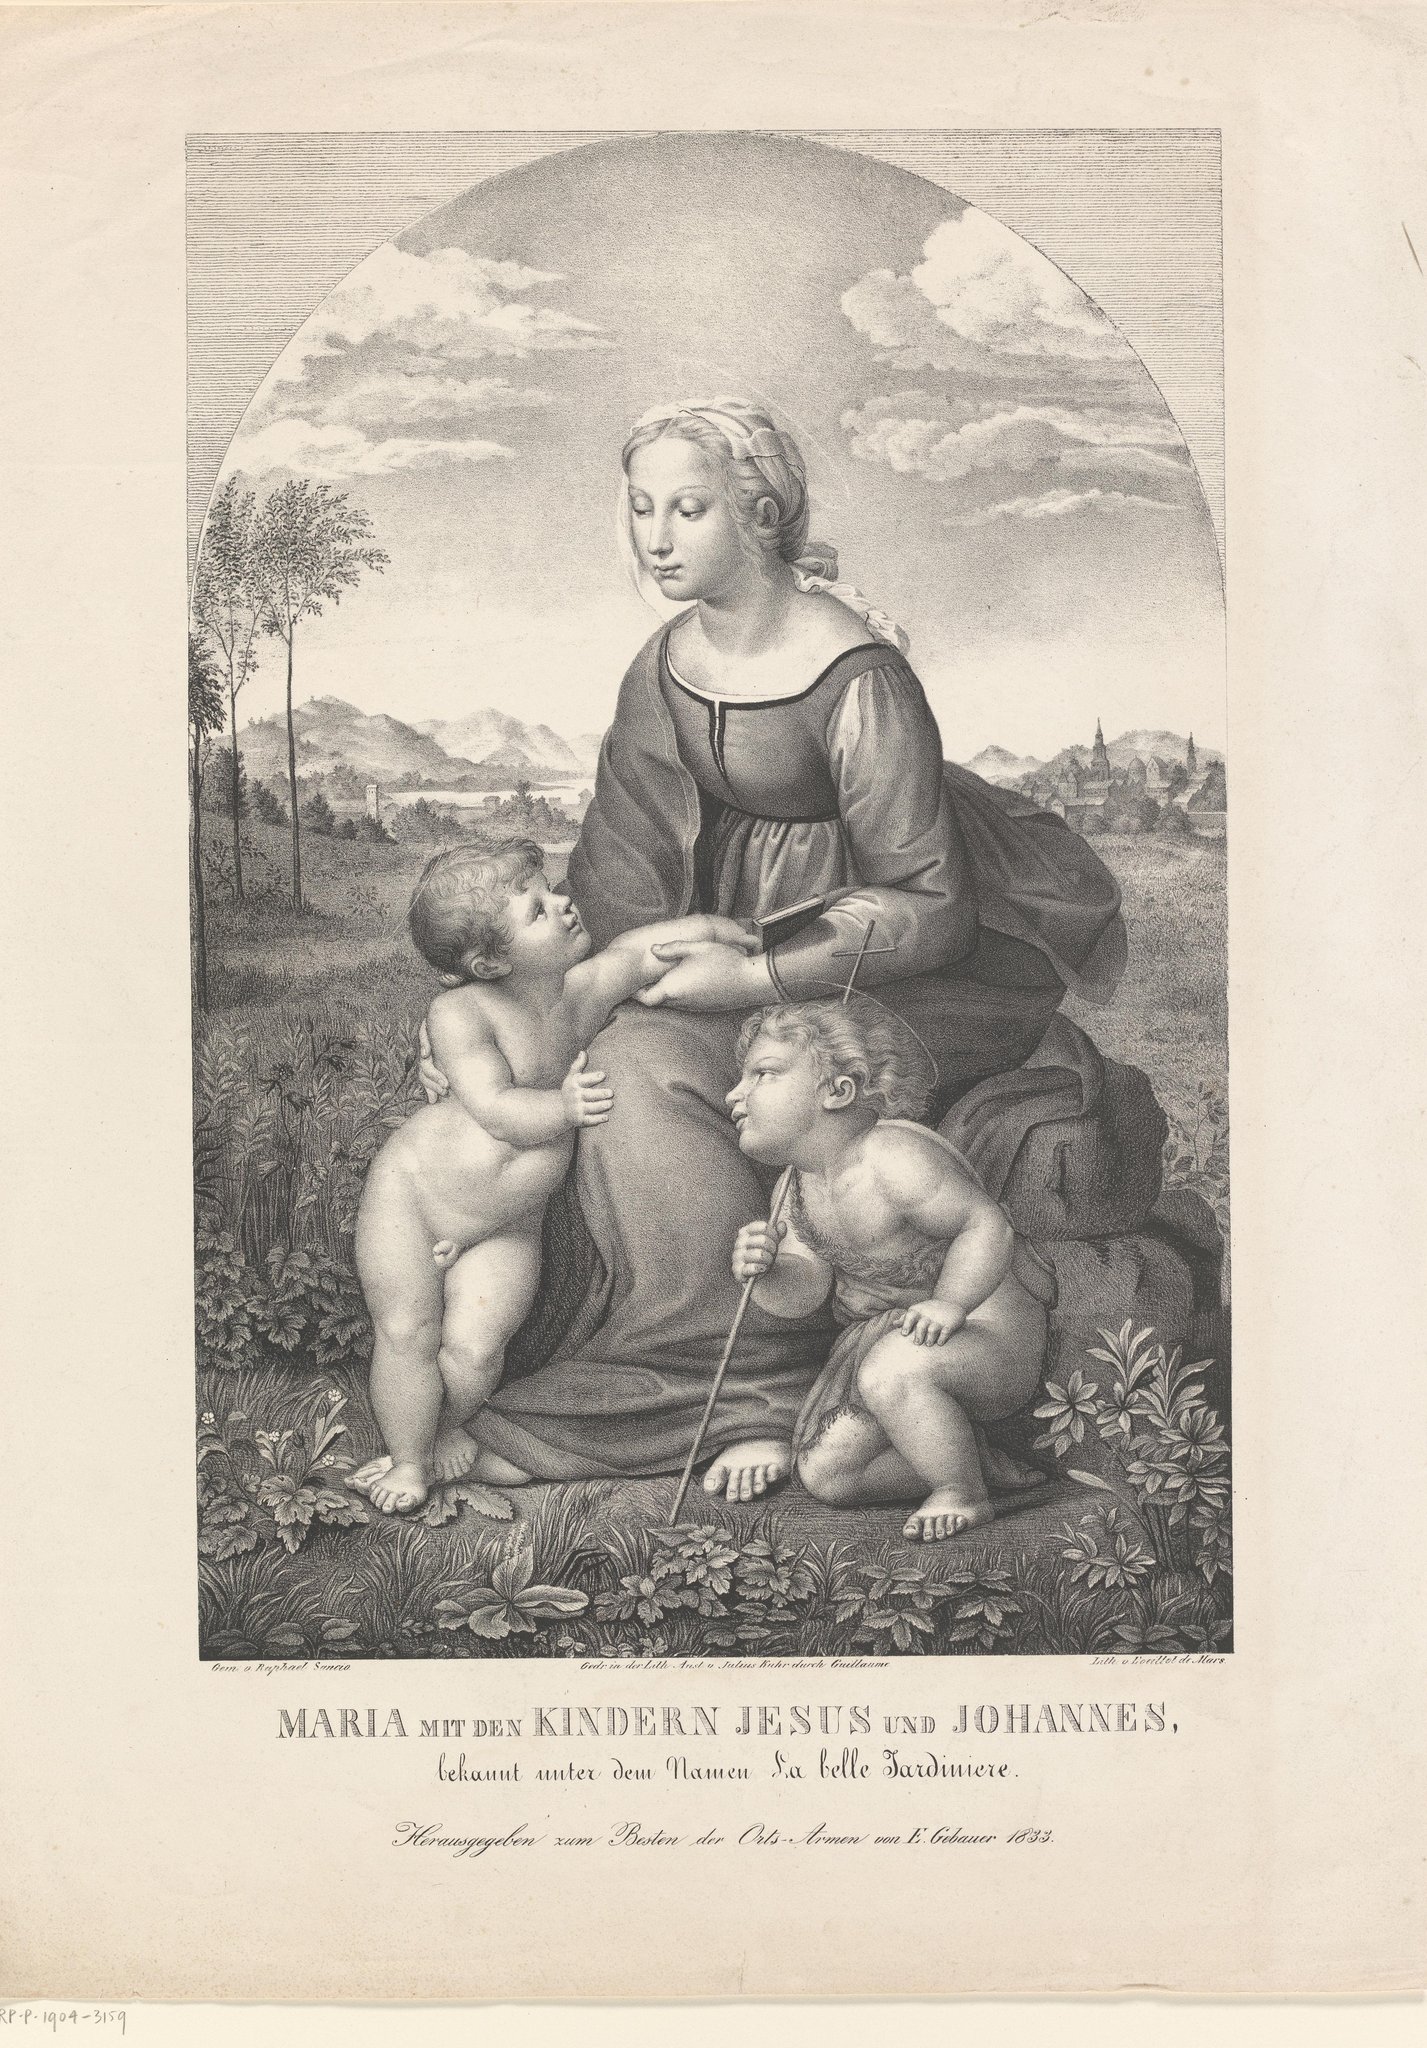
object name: print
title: Maria met de jonge Christus en Johannes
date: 1833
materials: paper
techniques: lithograph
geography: berlin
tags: the christ-child and john the baptist (as child) with others, sitting figures of mary (alone), city-view, and landscape with man-made constructions (+ city(-scape) with figures, staffage)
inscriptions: check stamp: ‘E. Gebauer in Berlin’, collector's mark: Lugt 2228